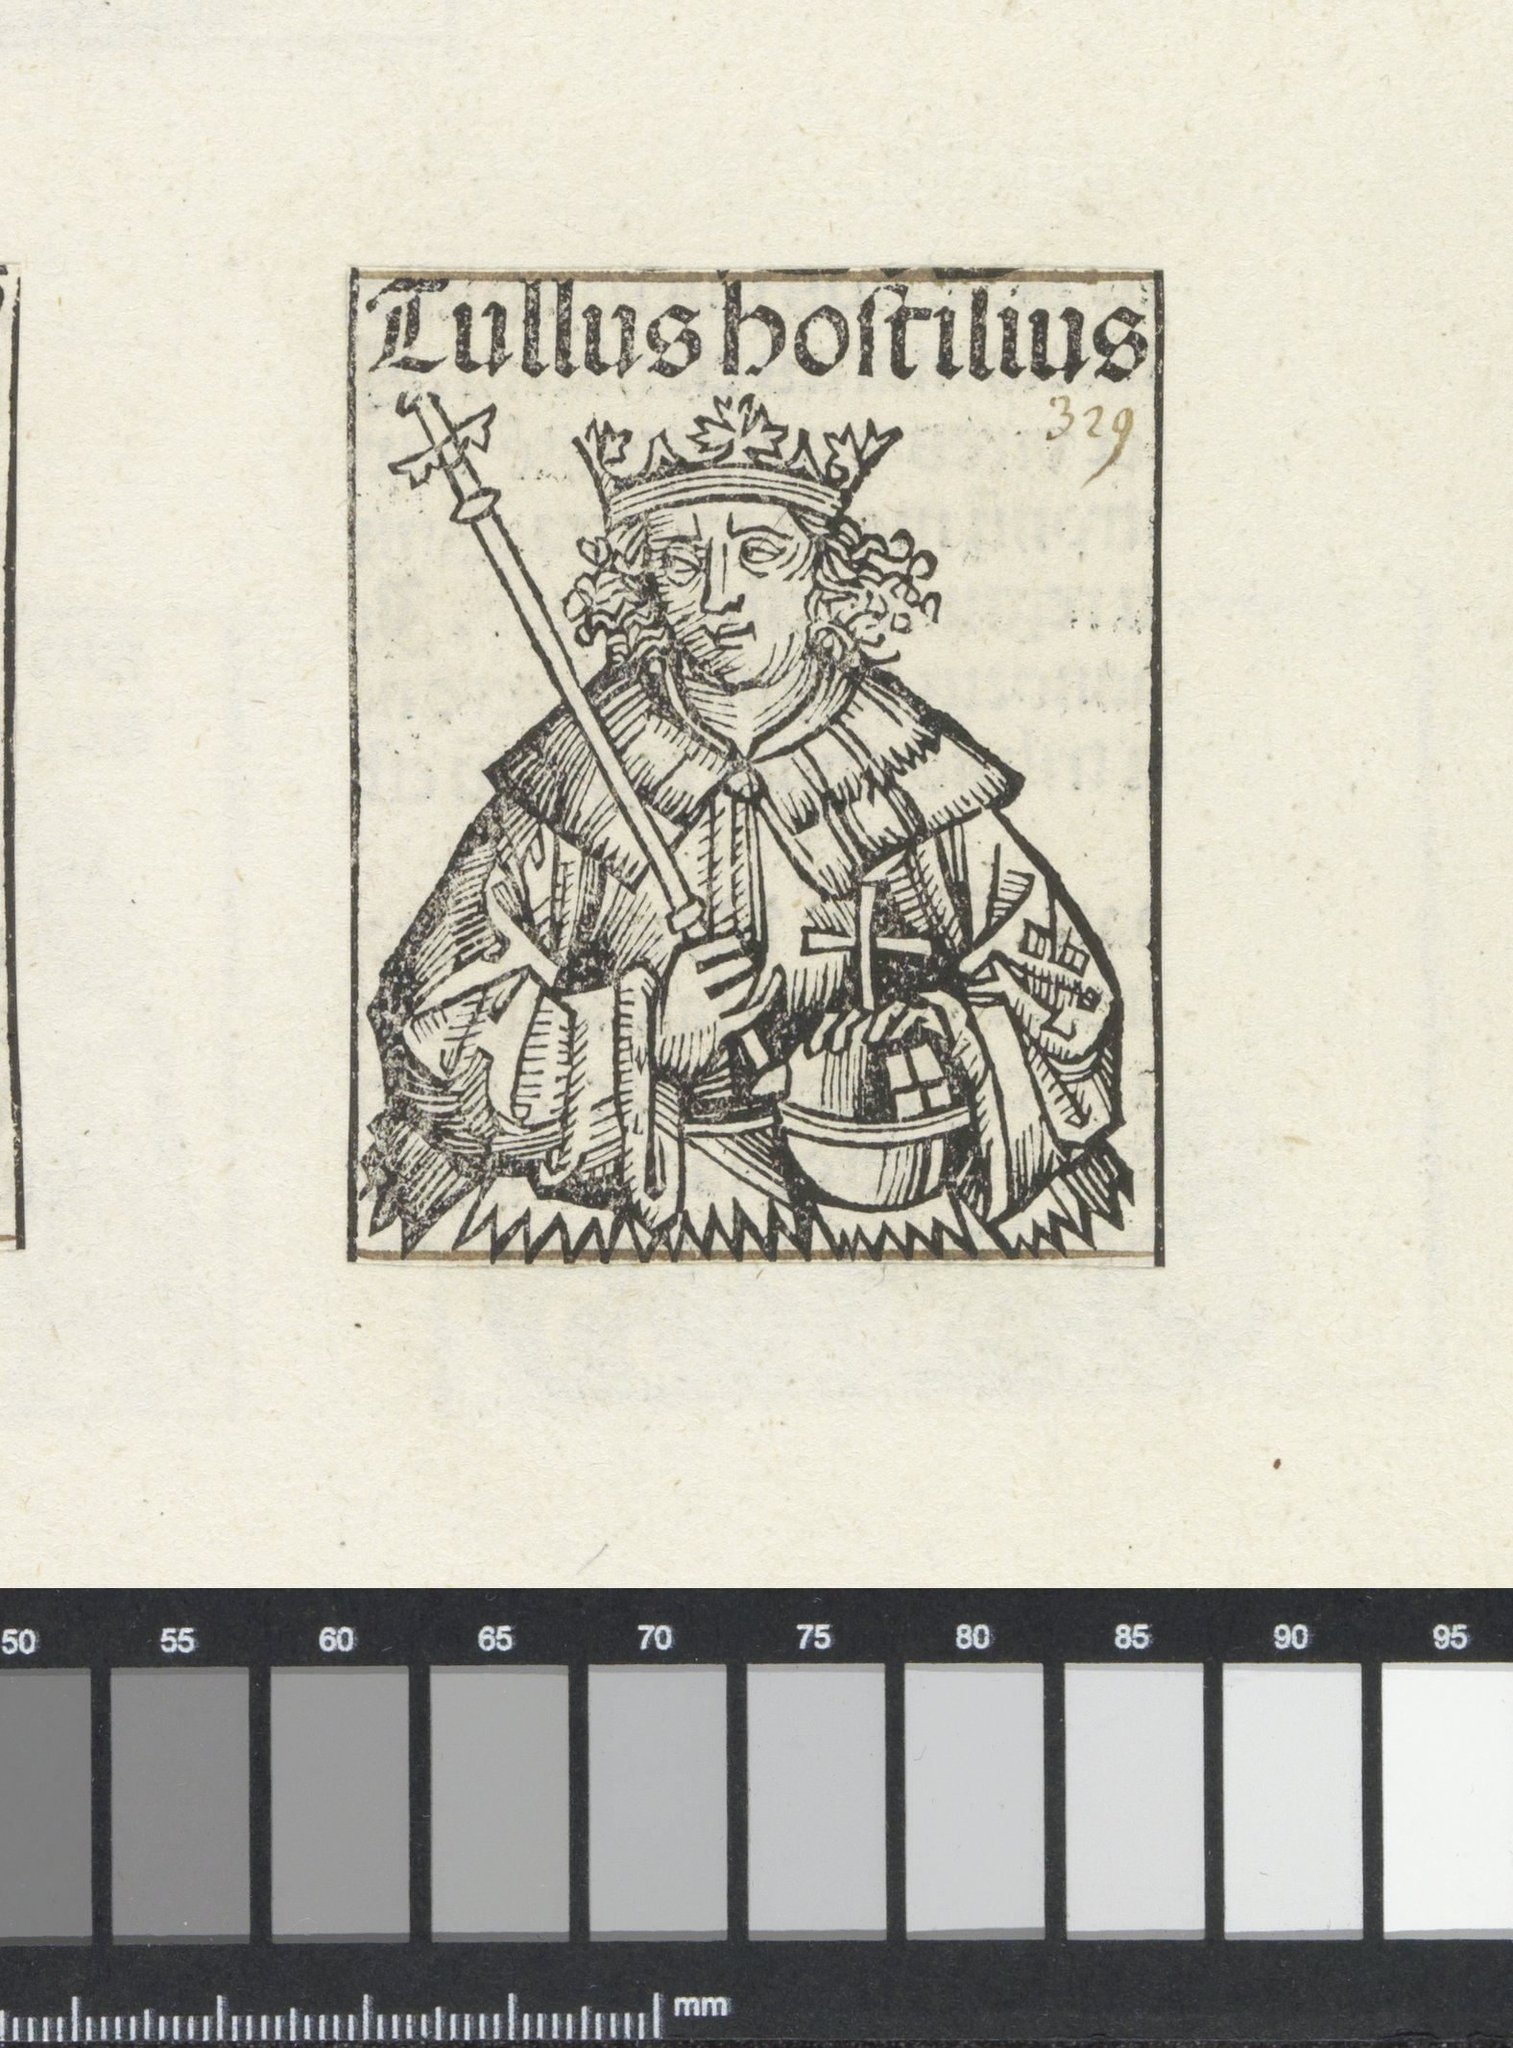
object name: print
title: Liber Chronicarum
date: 1493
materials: paper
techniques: letterpress printing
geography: nuremberg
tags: king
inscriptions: inscription: ‘329’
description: Een bloemkelk met een koning, naar voren gekeerd. Hij heeft een scepter en rijksappel in zijn handen. De voorstelling is onderdeel van de opeenvolging Romeinse koningen in de Liber Chronicarum. De tekst identificeert de man als Tullus Hostilius. De prent maakt deel uit van een album.